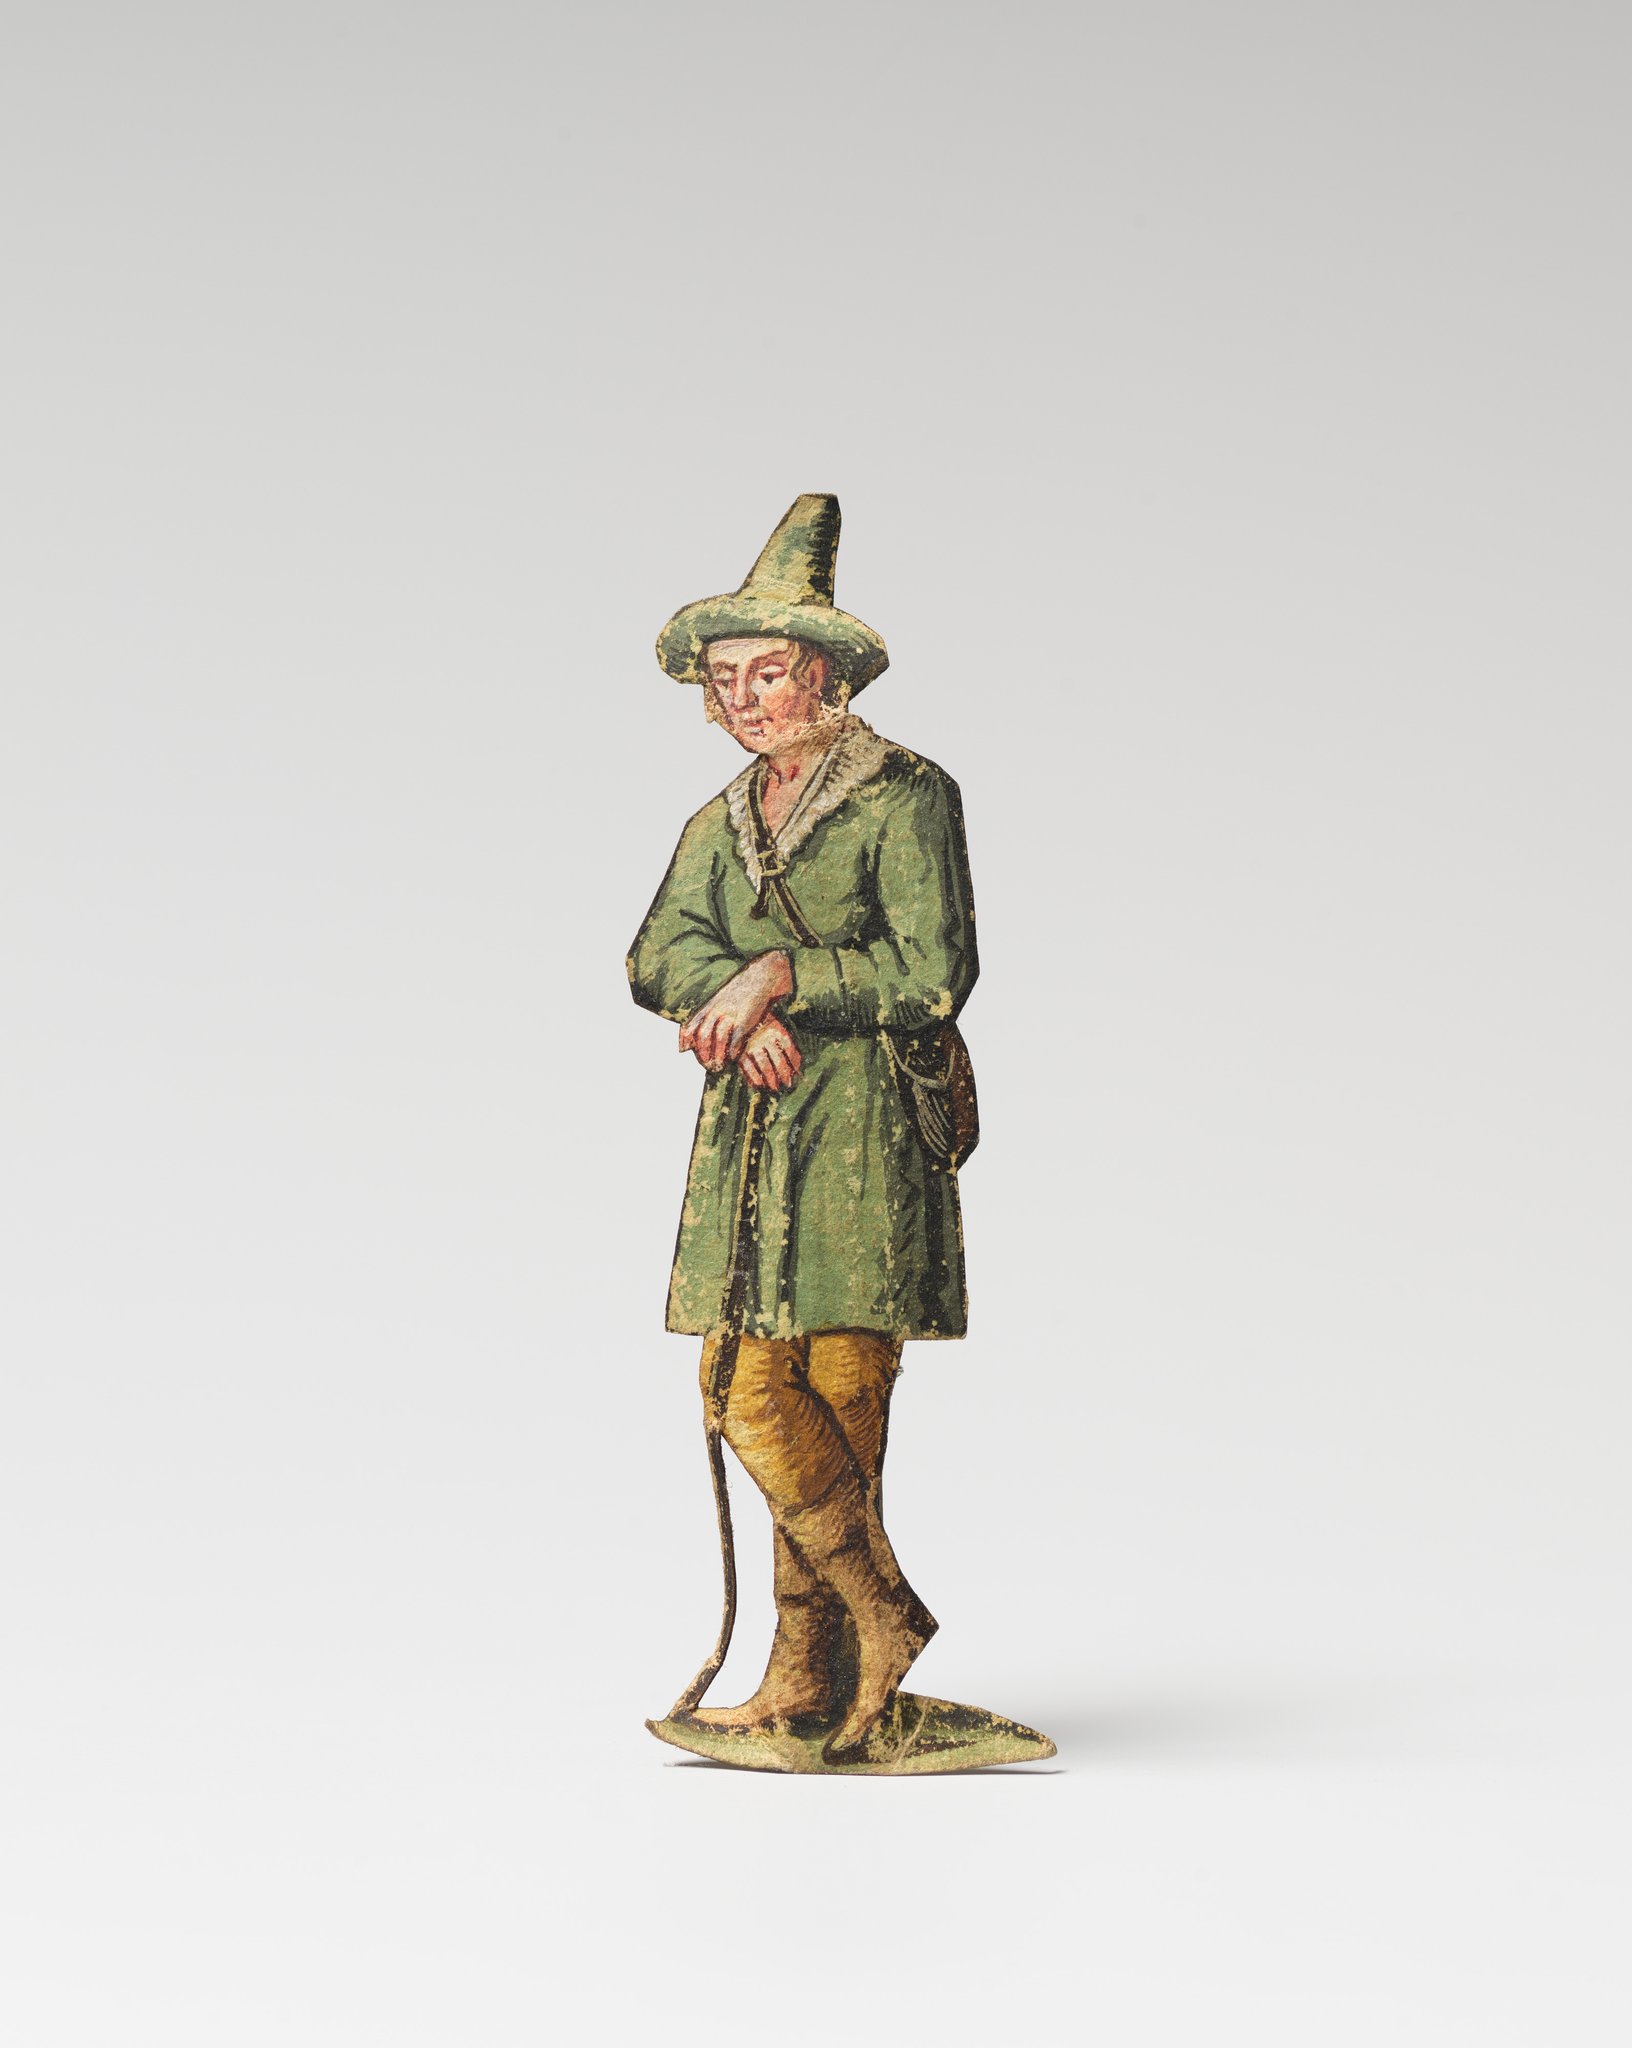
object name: figure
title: Shepherd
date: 1701-1800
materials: gouache, paper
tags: men,shepherds